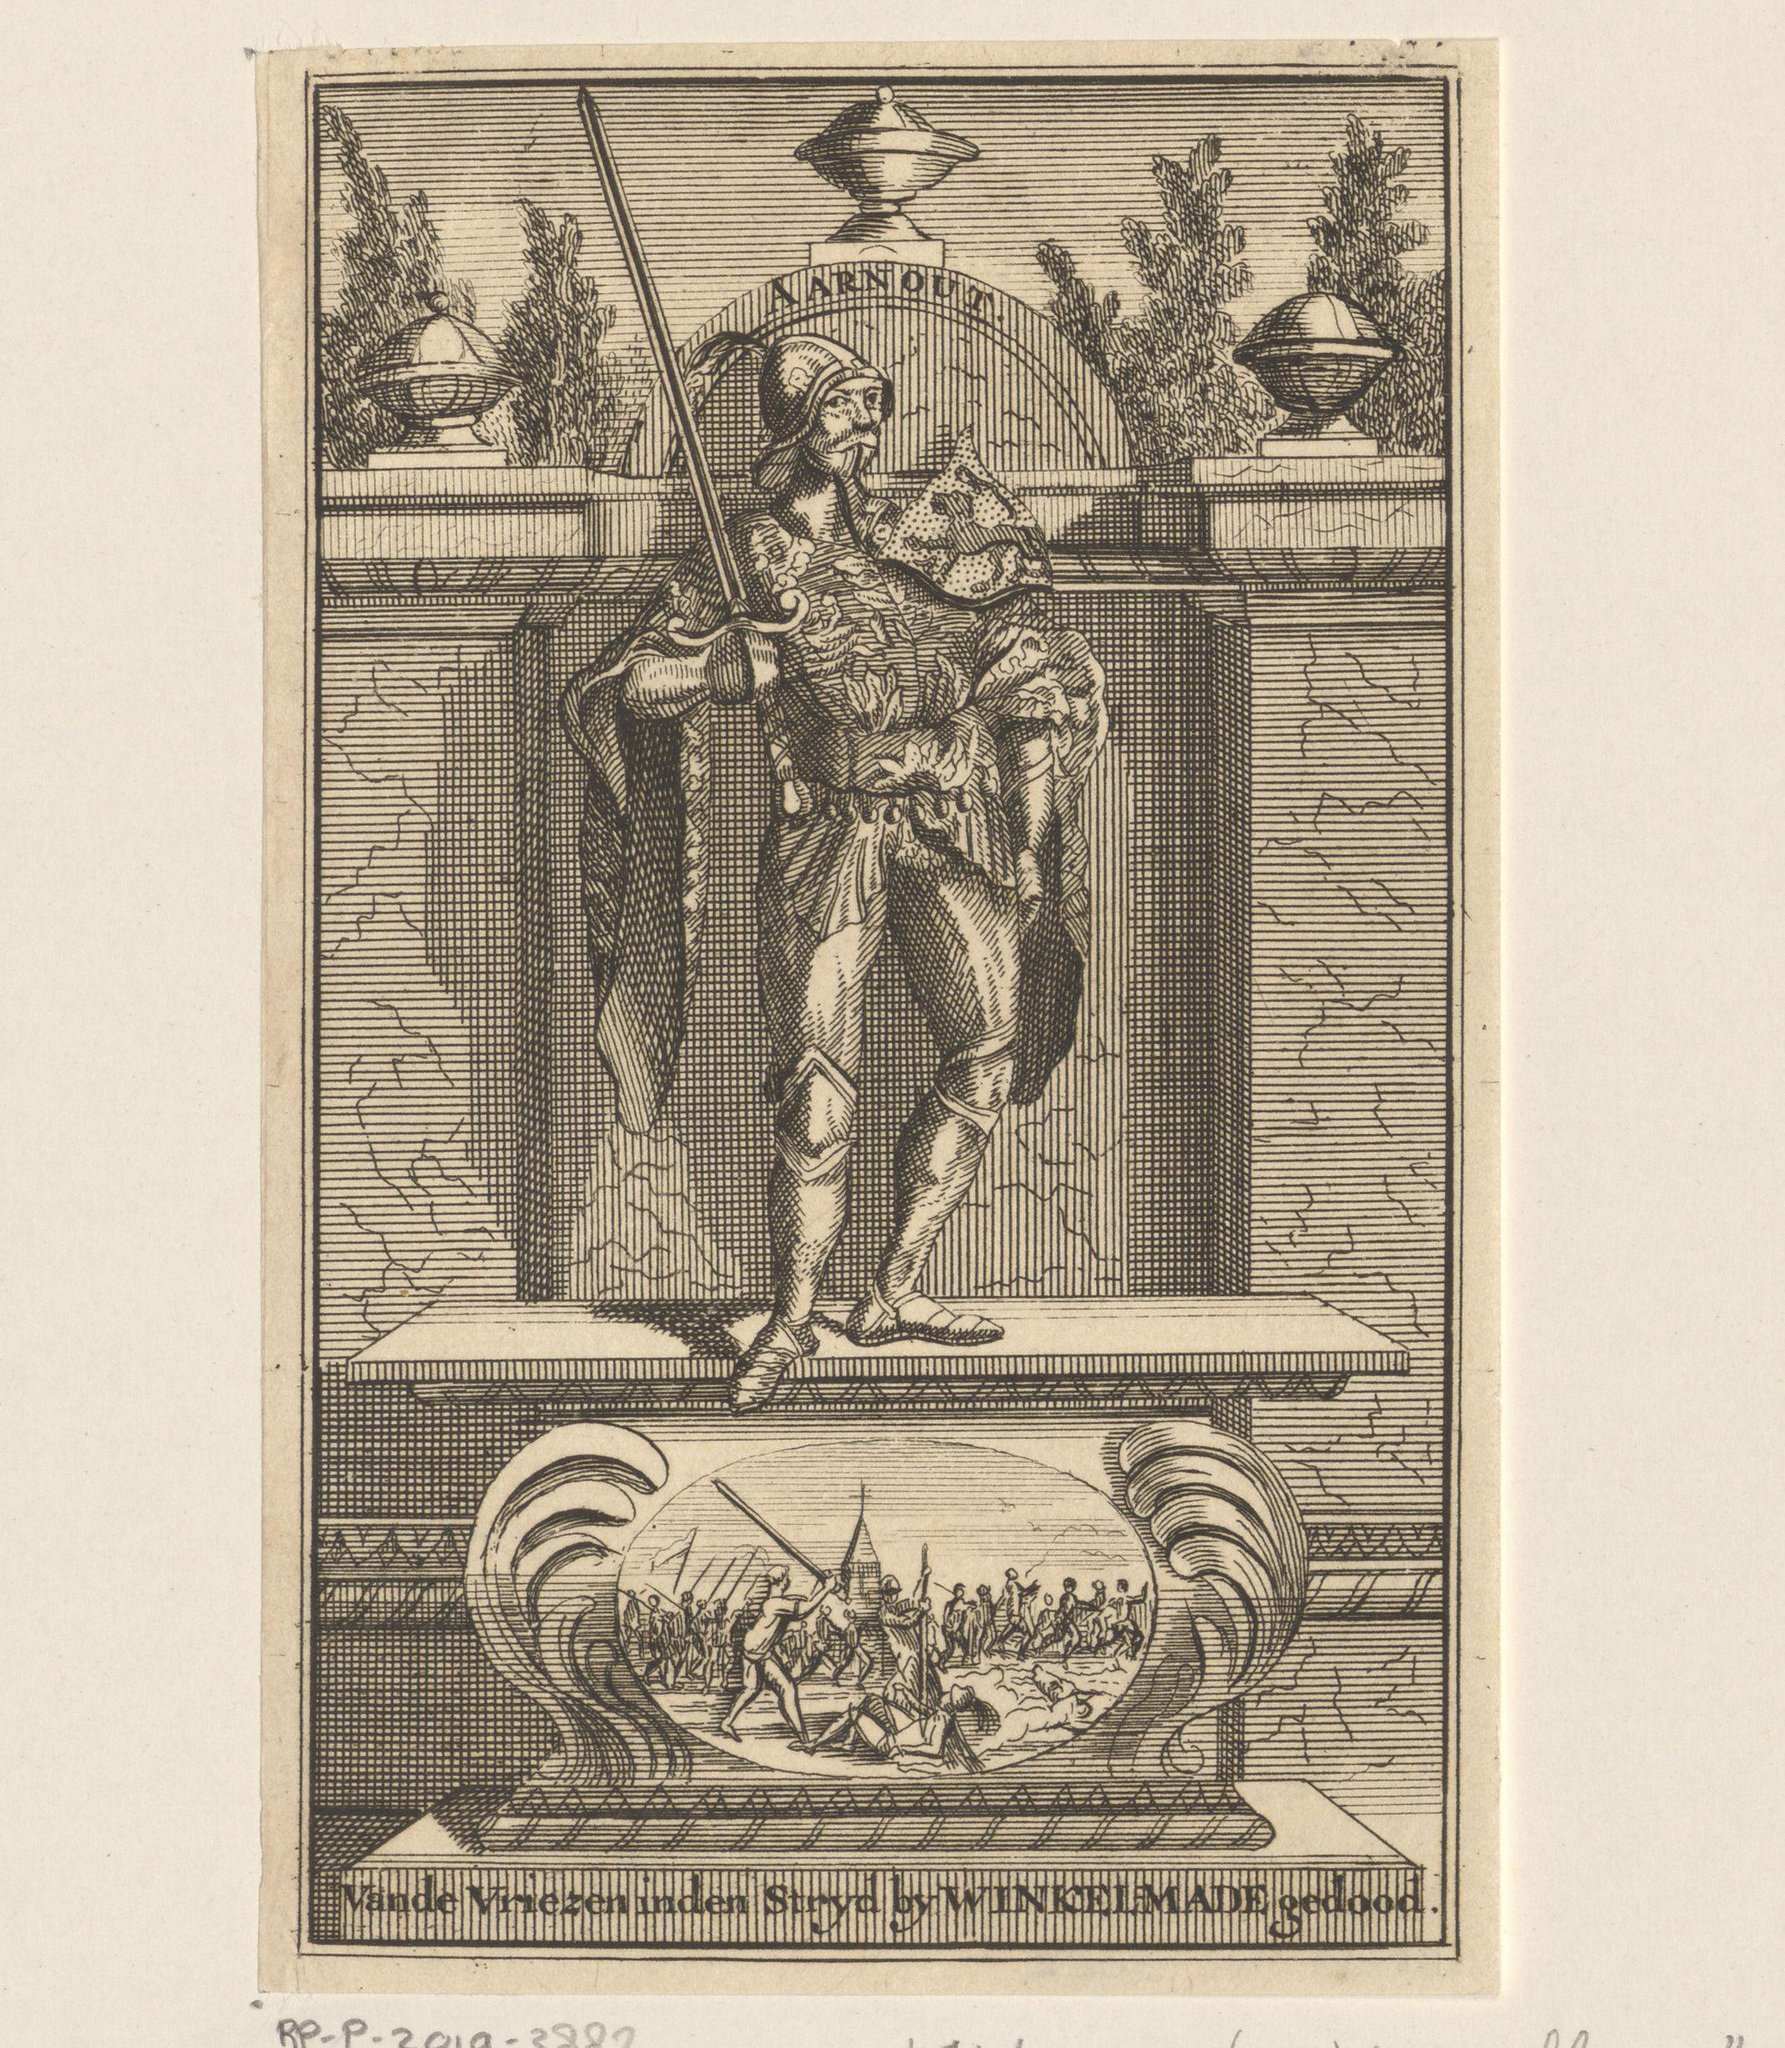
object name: print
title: Portret van Arnulf, graaf van Holland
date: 1702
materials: paper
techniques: etching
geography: amsterdam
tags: earl, armour, historical persons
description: Prent uit: Soeteboom, Hendrik Jacobsz. Oud-heden van Zaan-land, Stavoren, Vronen en Waterland. Amsterdam: Willem Linnig van Koppenol, 1702, dl. 2, p. 75. Prent mogelijk later nog verschenen in: Wagenaar, Jan. Vaderlandsche historie, vervattende de geschiedenissen der nu Vereenigde Nederlanden, inzonderheid die van Holland. Amsterdam: Isaak Tirion, 1749, en latere edities.